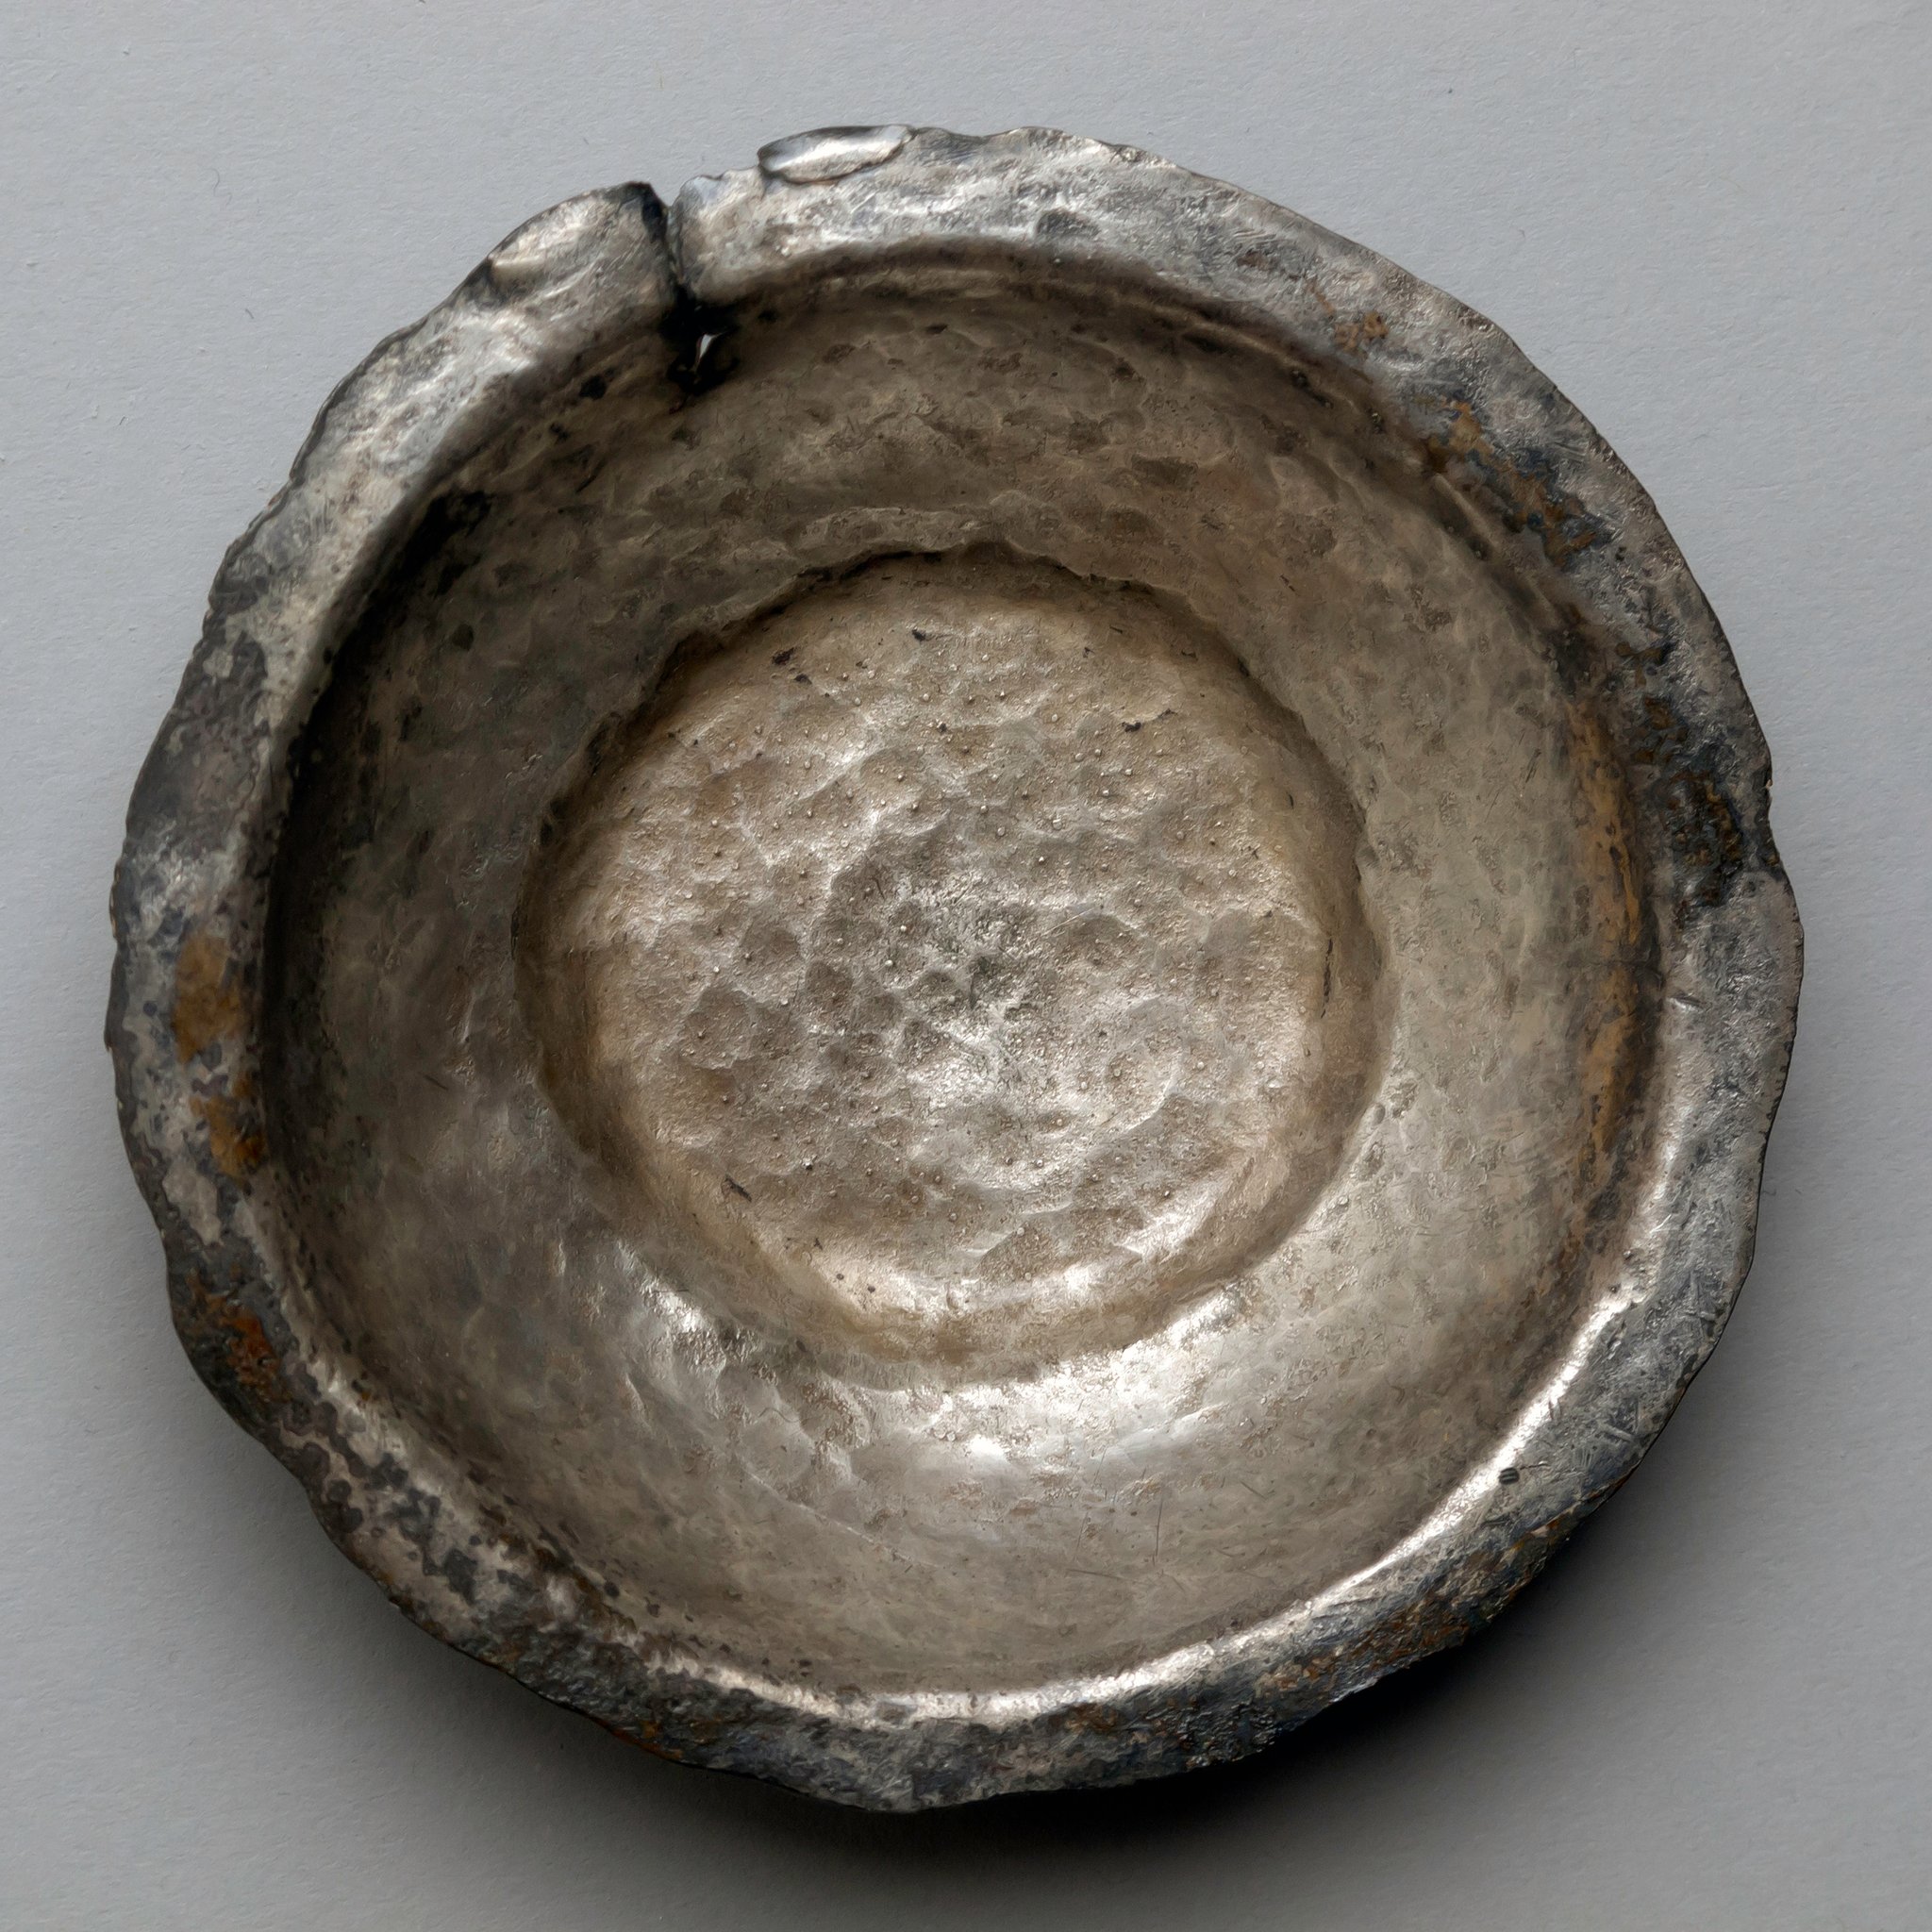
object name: bowl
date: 7000 BCE-330 CE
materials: silver